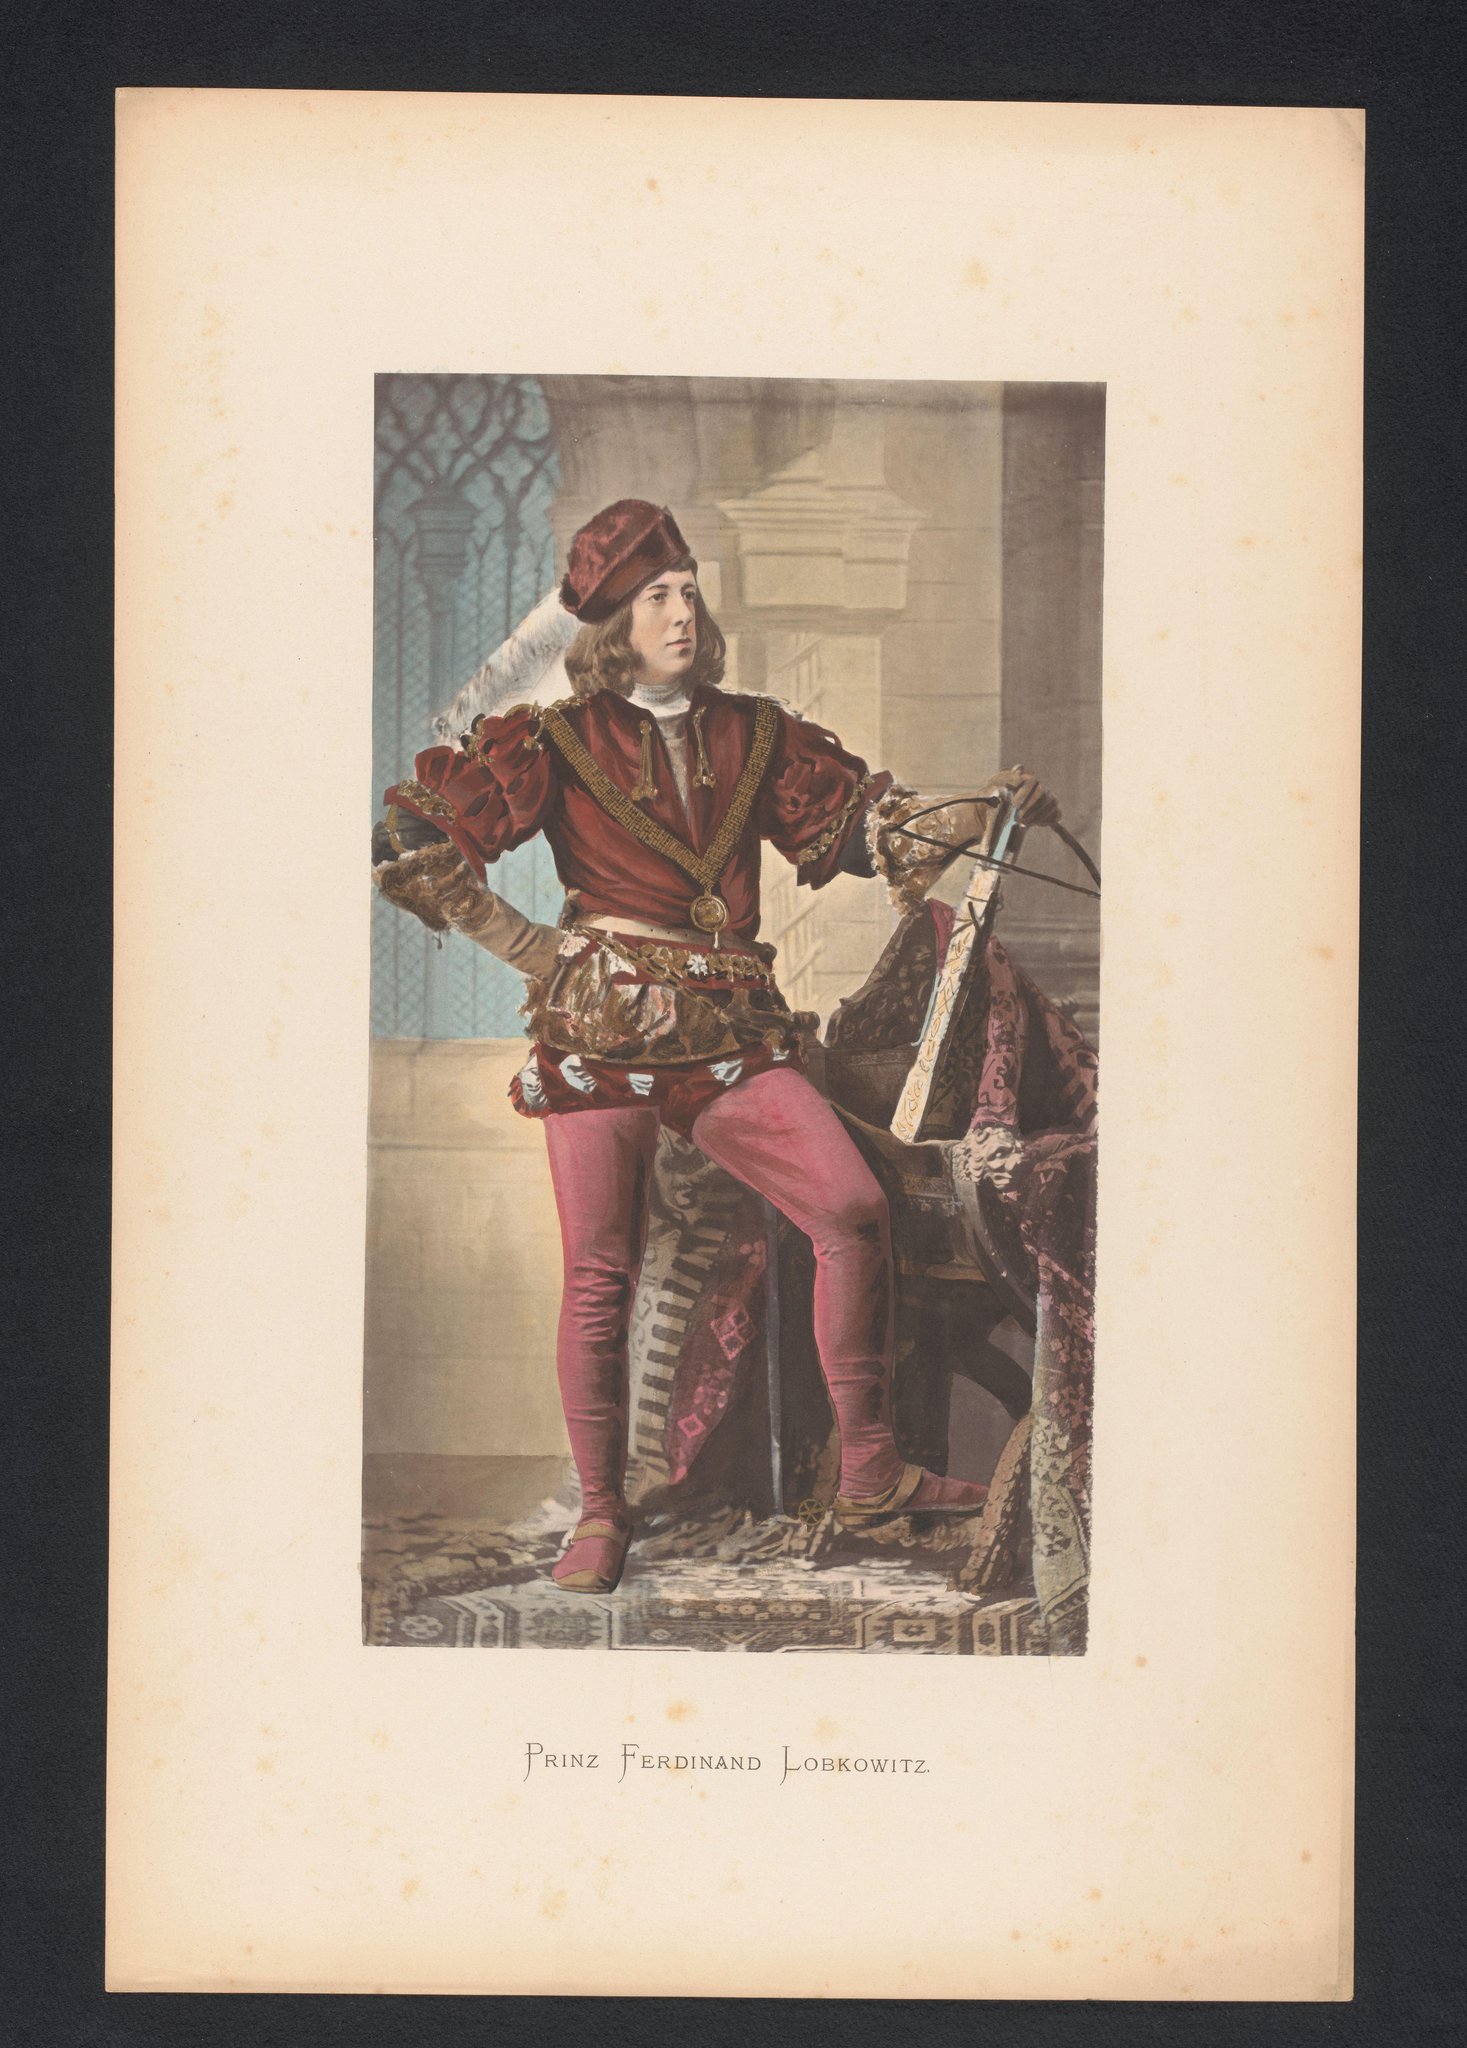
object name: photomechanical print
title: Prinz Ferdinand Lobkowitz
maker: Anonymous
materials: paper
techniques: photograph, hand coloring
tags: politician, aristocracy; 'aristocratia' (ripa), historical persons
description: Deze prent maakt deel uit van een omslag met 86 prenten op 78 bladen en 11 tekstbladen.